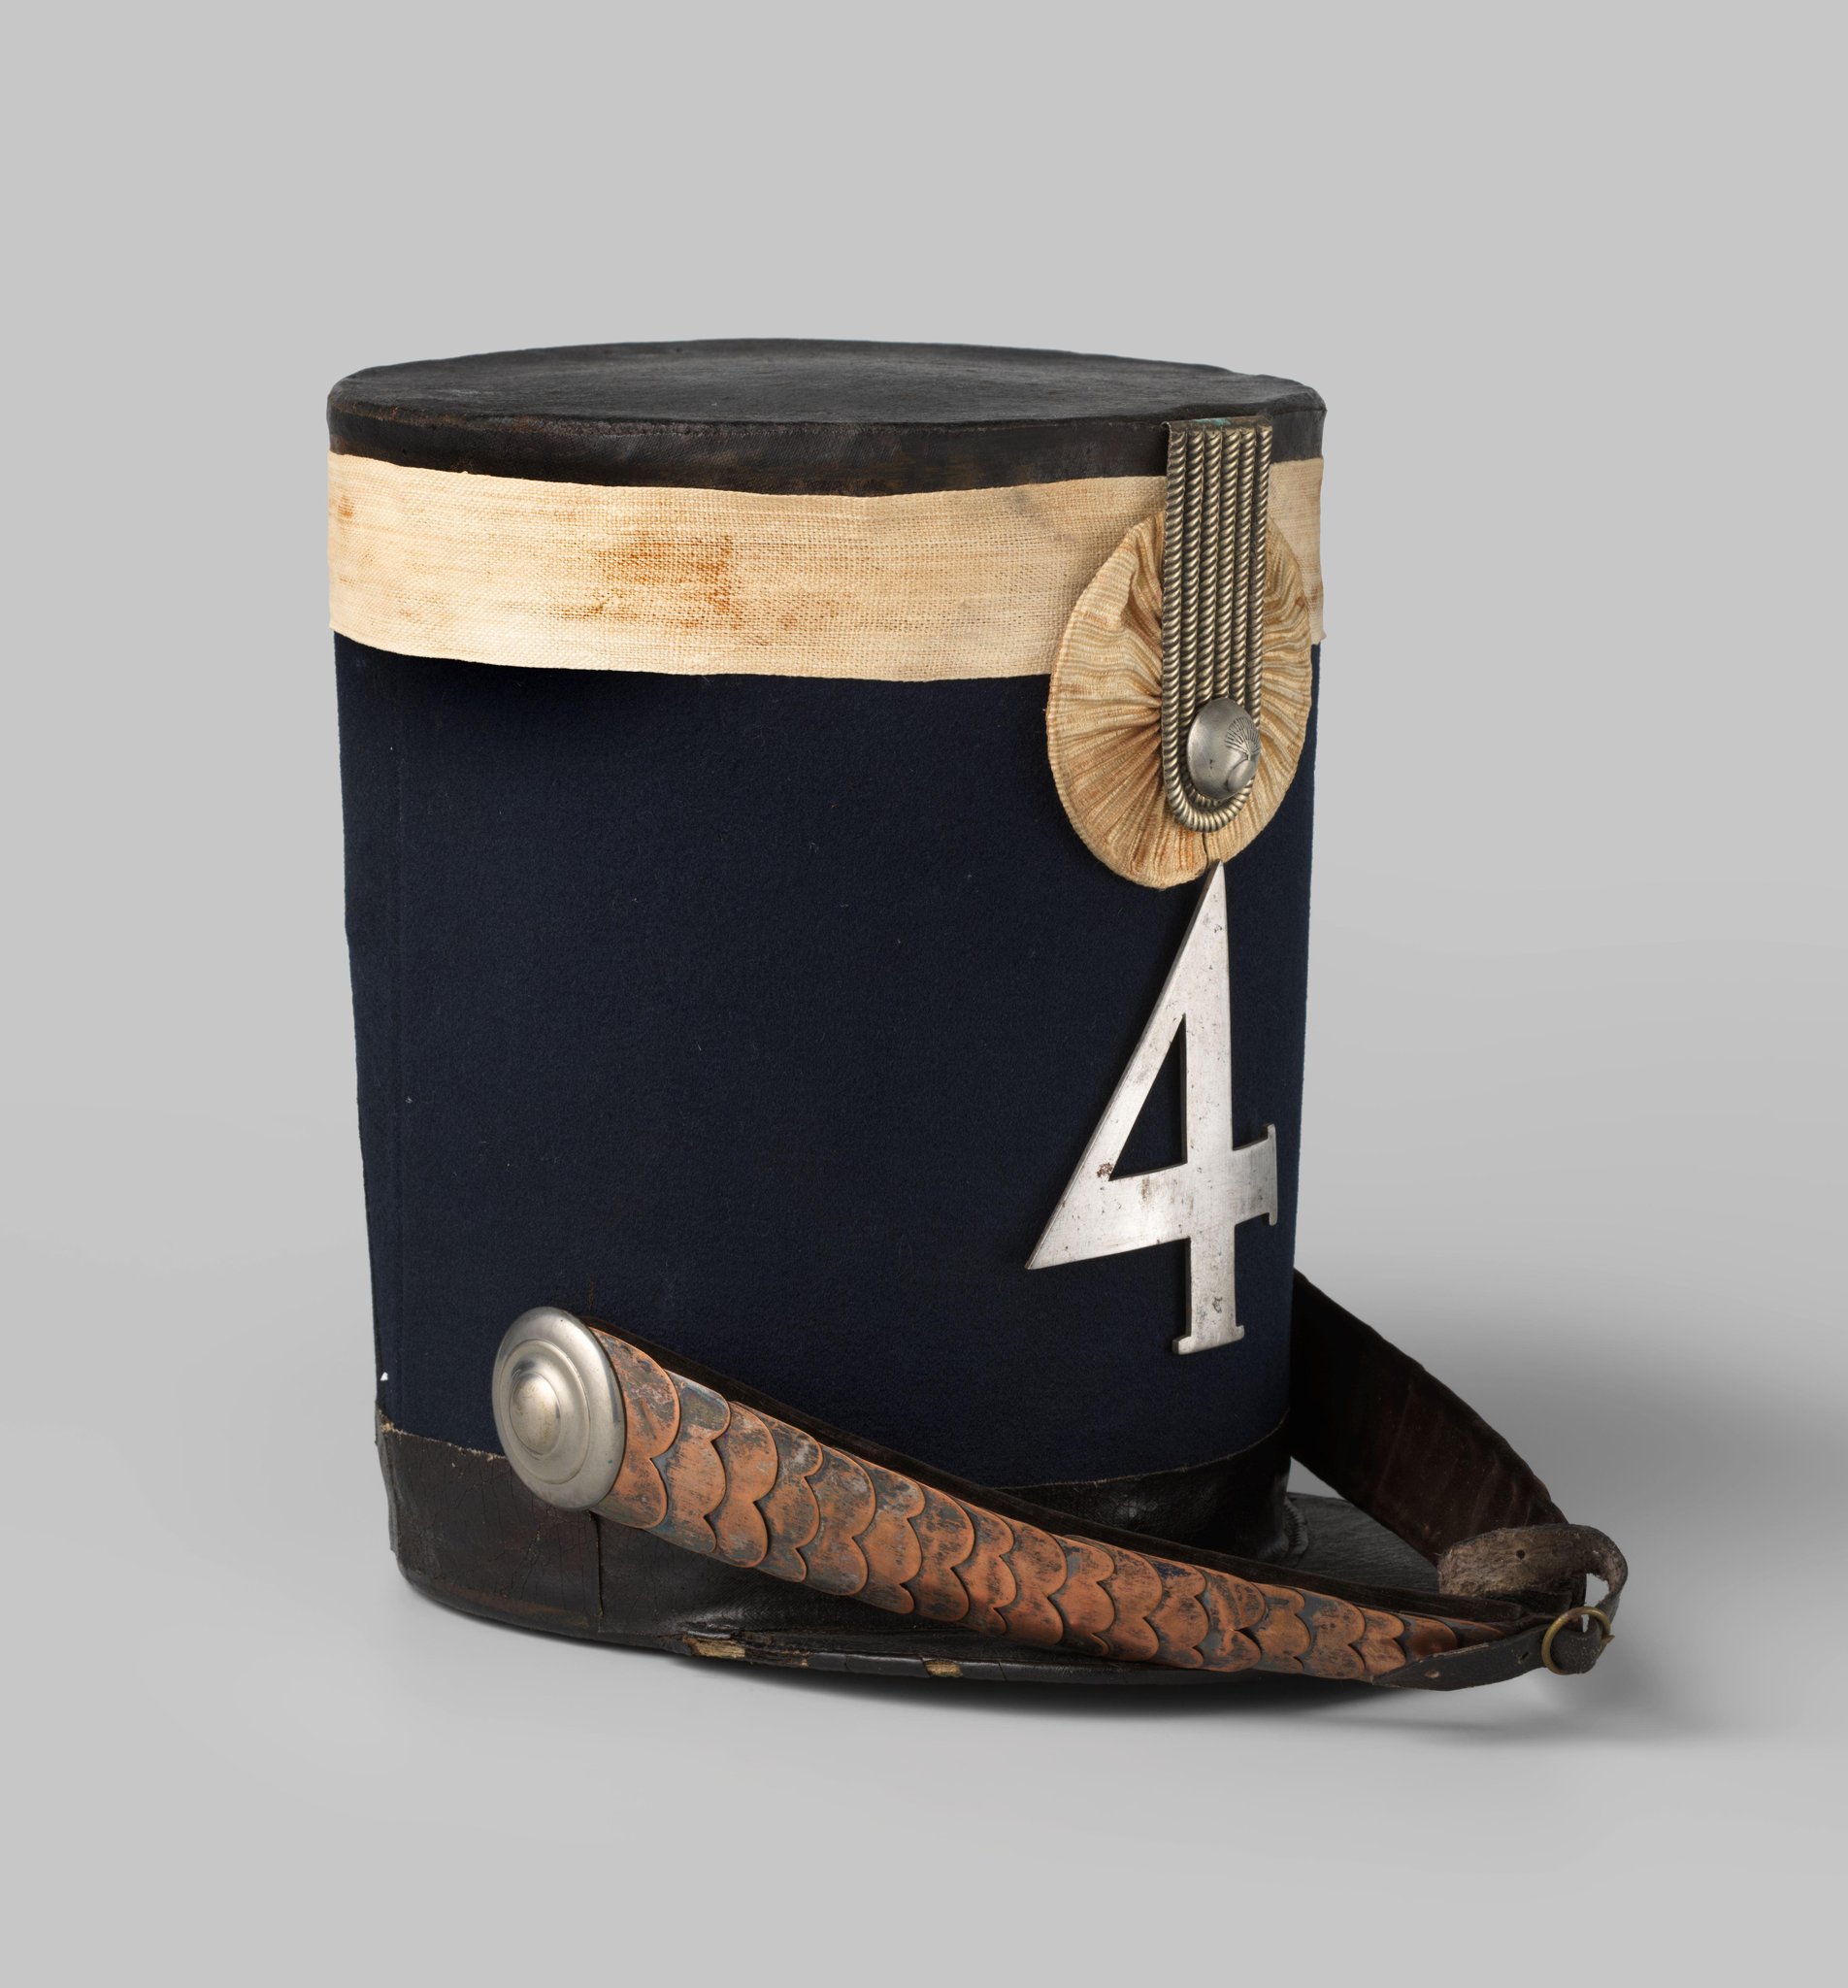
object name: shako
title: Sjako van regiment Dragonders no. 4, M 1823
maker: Anonymous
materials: cardboard, textile, copper, leather, linen, silk, wood, wool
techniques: braiding, stitching, striking, tanning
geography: netherlands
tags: netherlands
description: Hoofddeksel van donkerblauw laken, achterzijde zwart laken. Zwart gelakte linnen bodem, waaromheen brede witte linnen band. Voorzijde: wit wollen pompon met wit metalen lis en knoop met granaat. Hieronder oranje zijden kokarde. Twee opgenomen kinbanden van weggepoetst wit emtaal (geel metaal zichtbaar), gemonteerd op zwart fluwelen leren band met gesp. Wit metalen rozetten. Wit metalen 4. Achterzijde: wit metalen knoop met granaat. Onderzijde sjako is afgezet met zwart gelakte linnen band. Op onderzijde klep een etiket met LS. Binnenwerk: zwart leer met dito veter.